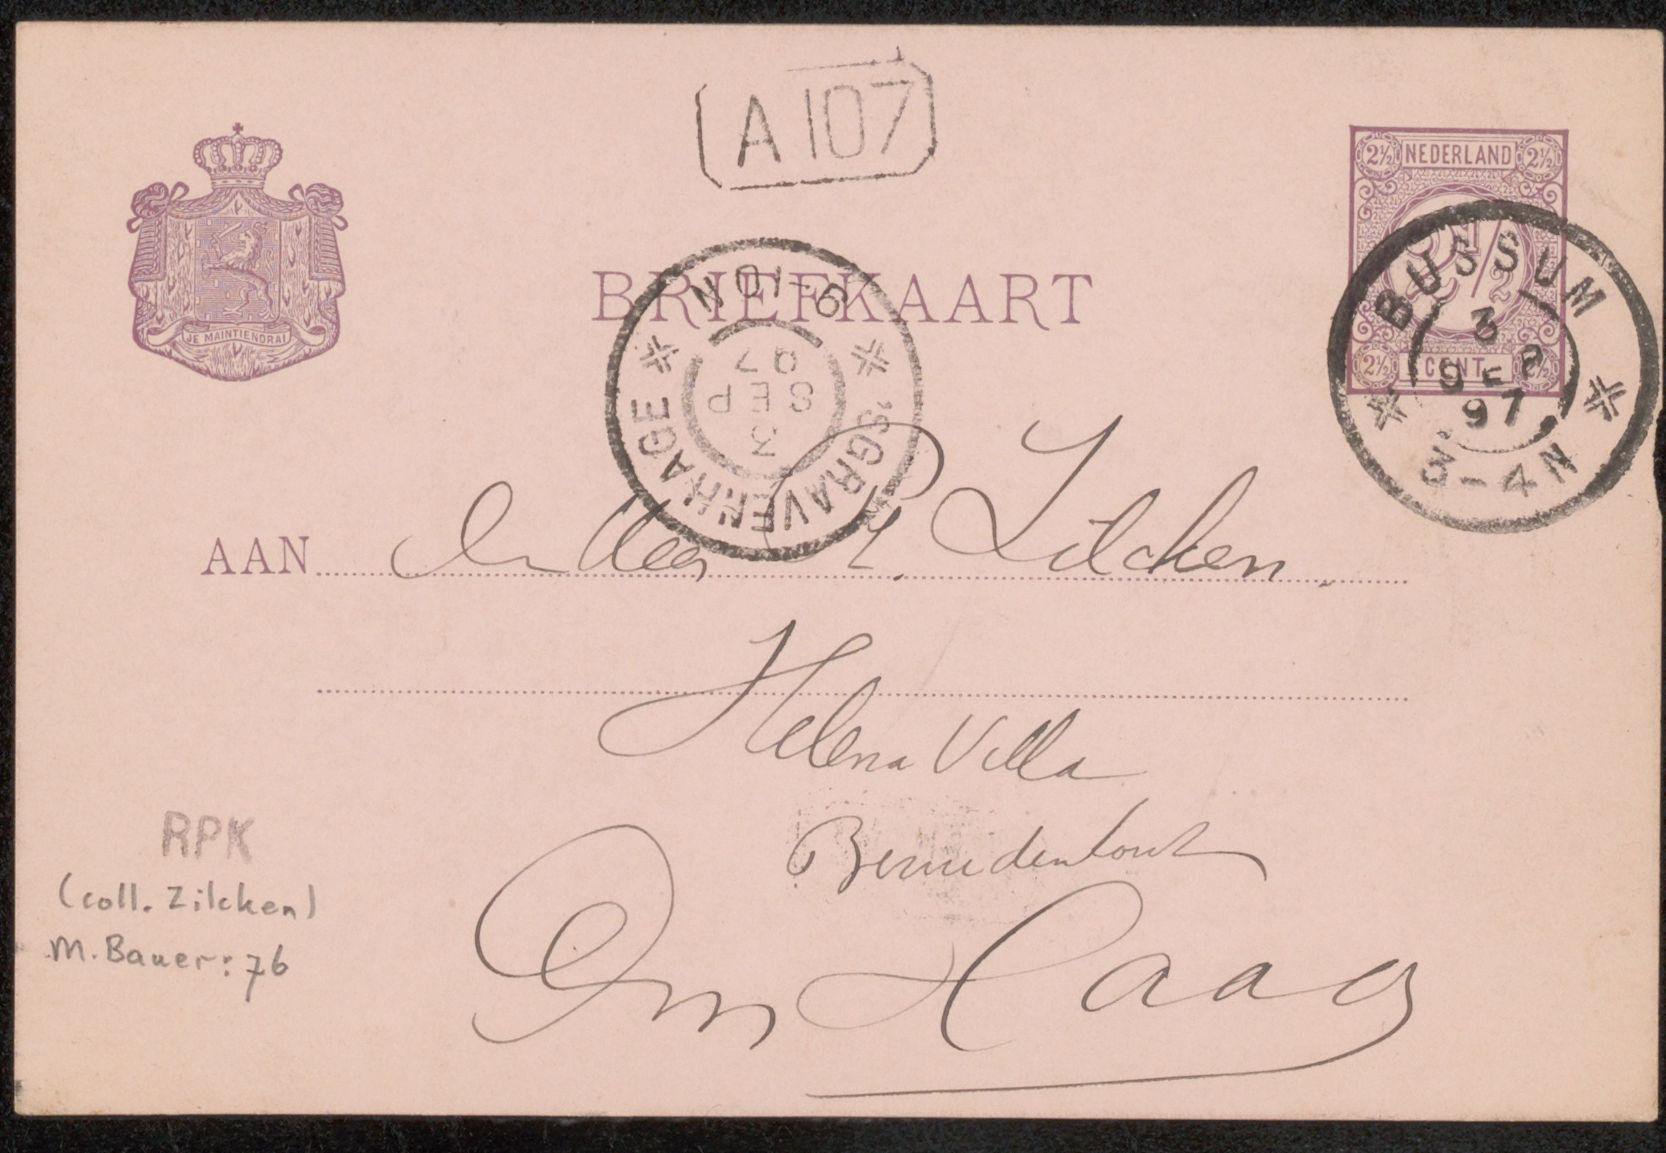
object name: postcard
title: Briefkaart aan Philip Zilcken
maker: marius bauer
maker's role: draughtsman, print maker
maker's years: 1867-1932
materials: cardboard, ink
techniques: pen, writing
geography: bussum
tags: painter, philip zilcken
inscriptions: collector's mark: ‘RPK’